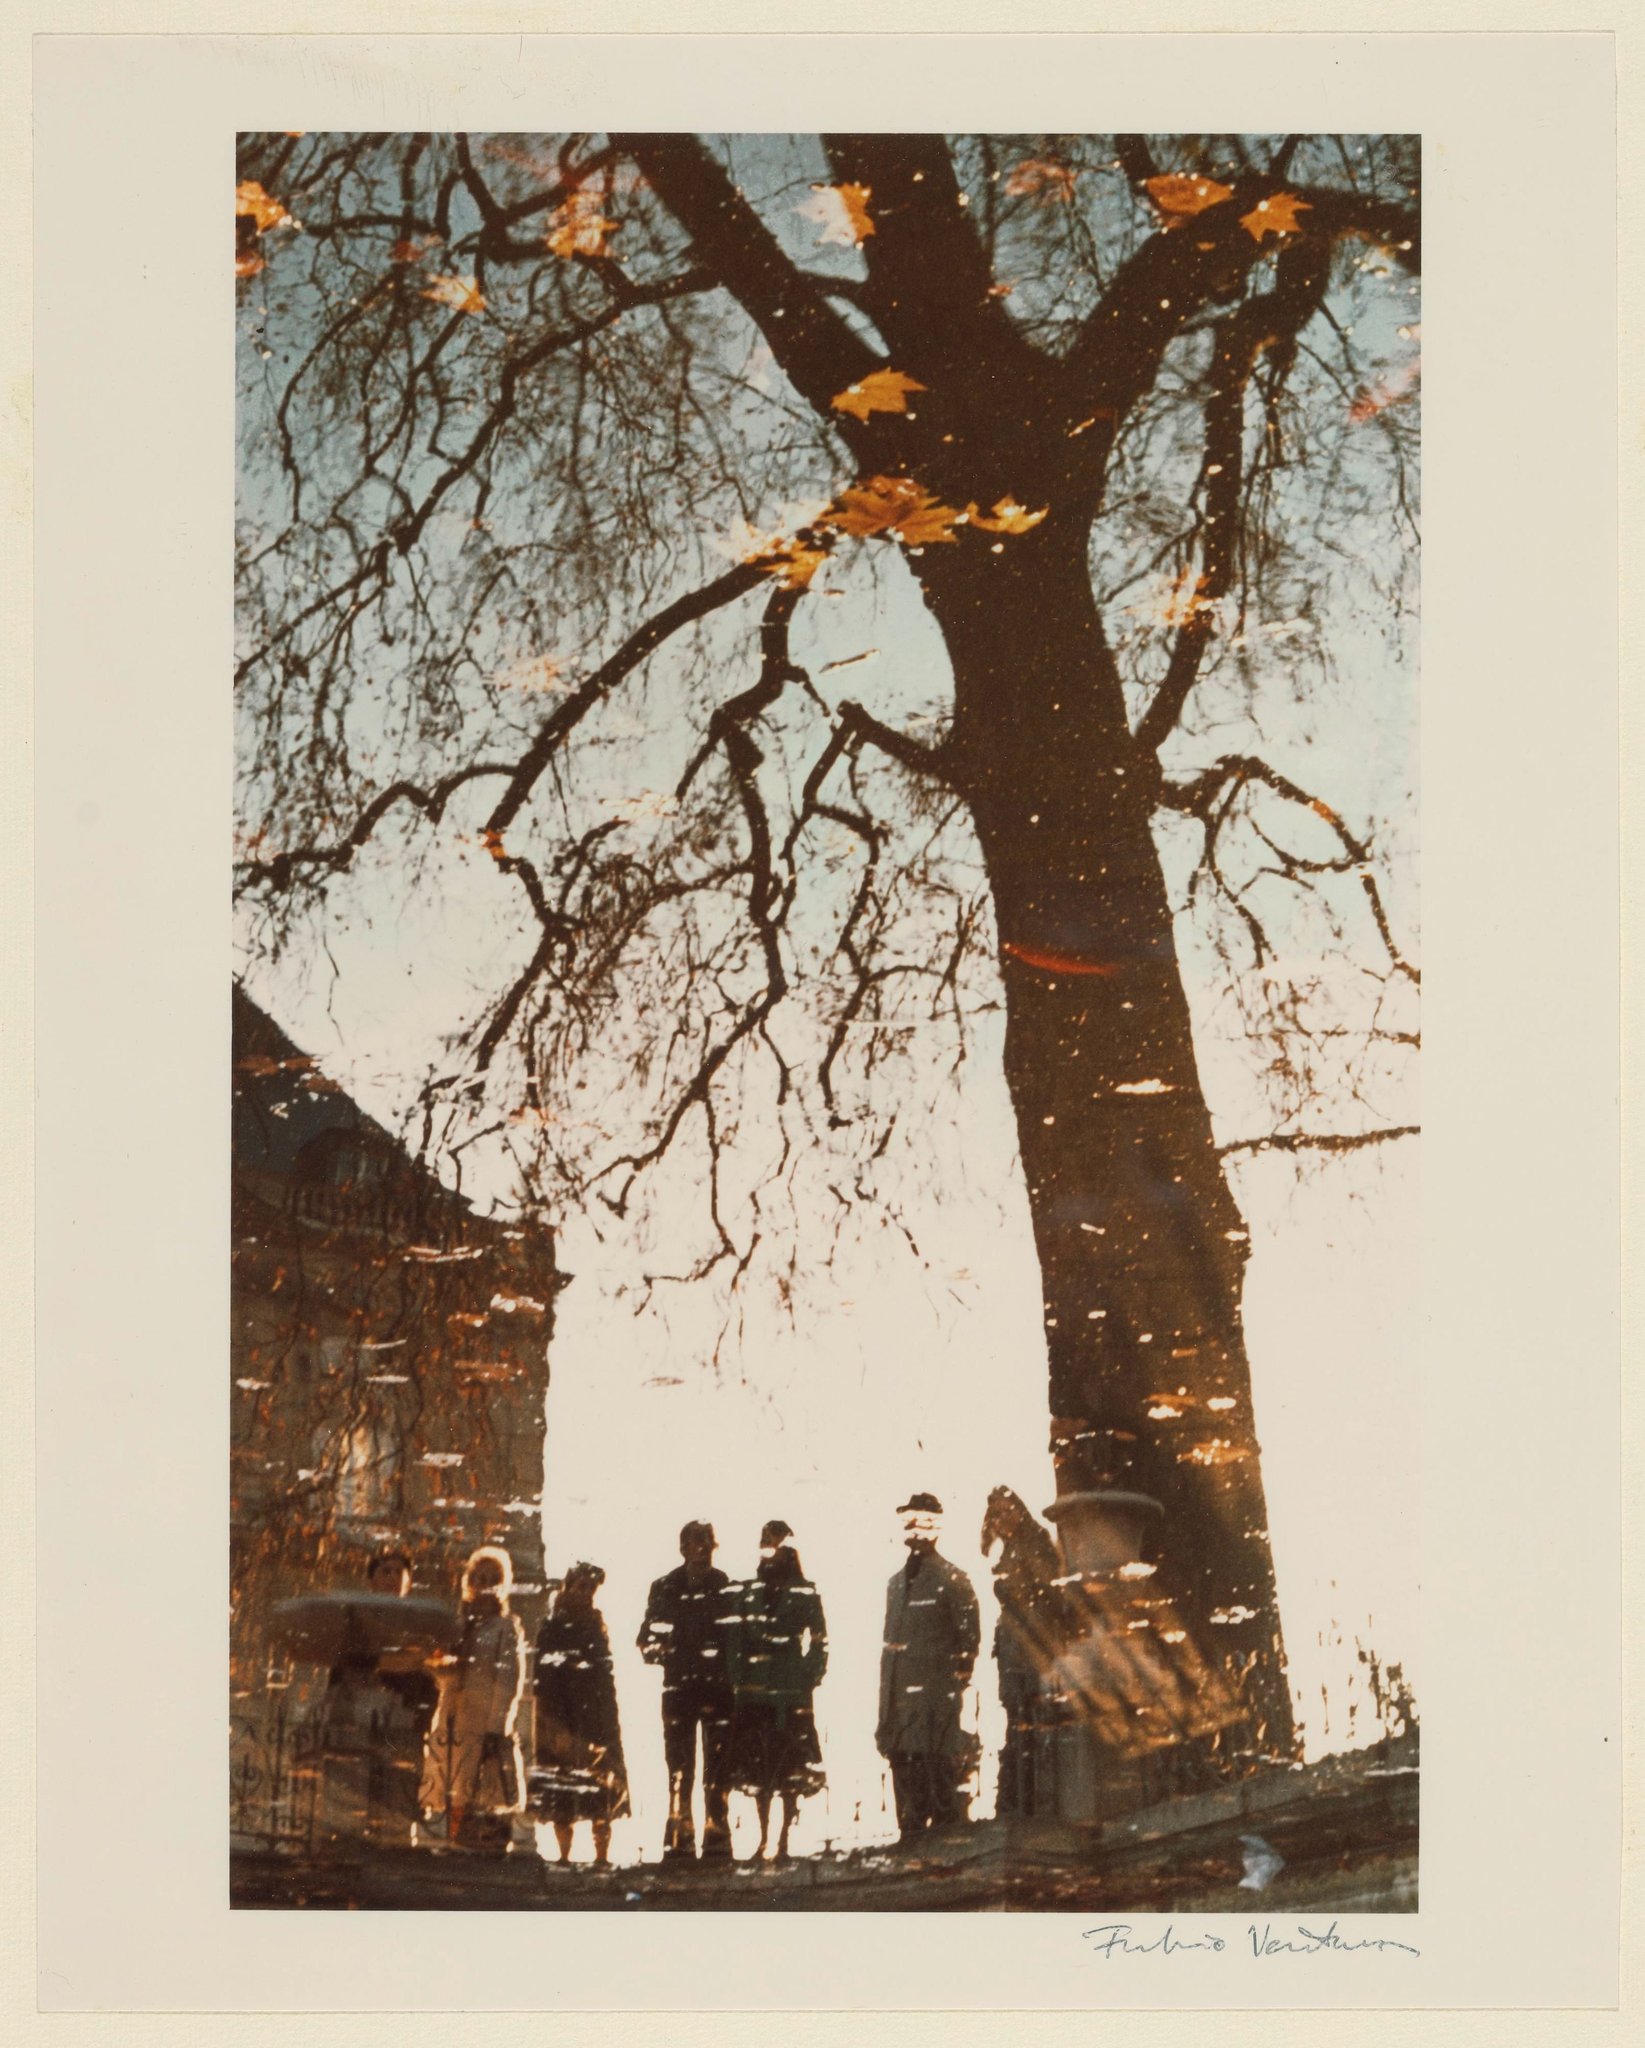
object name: photograph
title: mensen naast huis onder boom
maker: fabio ventura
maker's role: fotograaf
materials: photographic support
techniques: chromogenic print